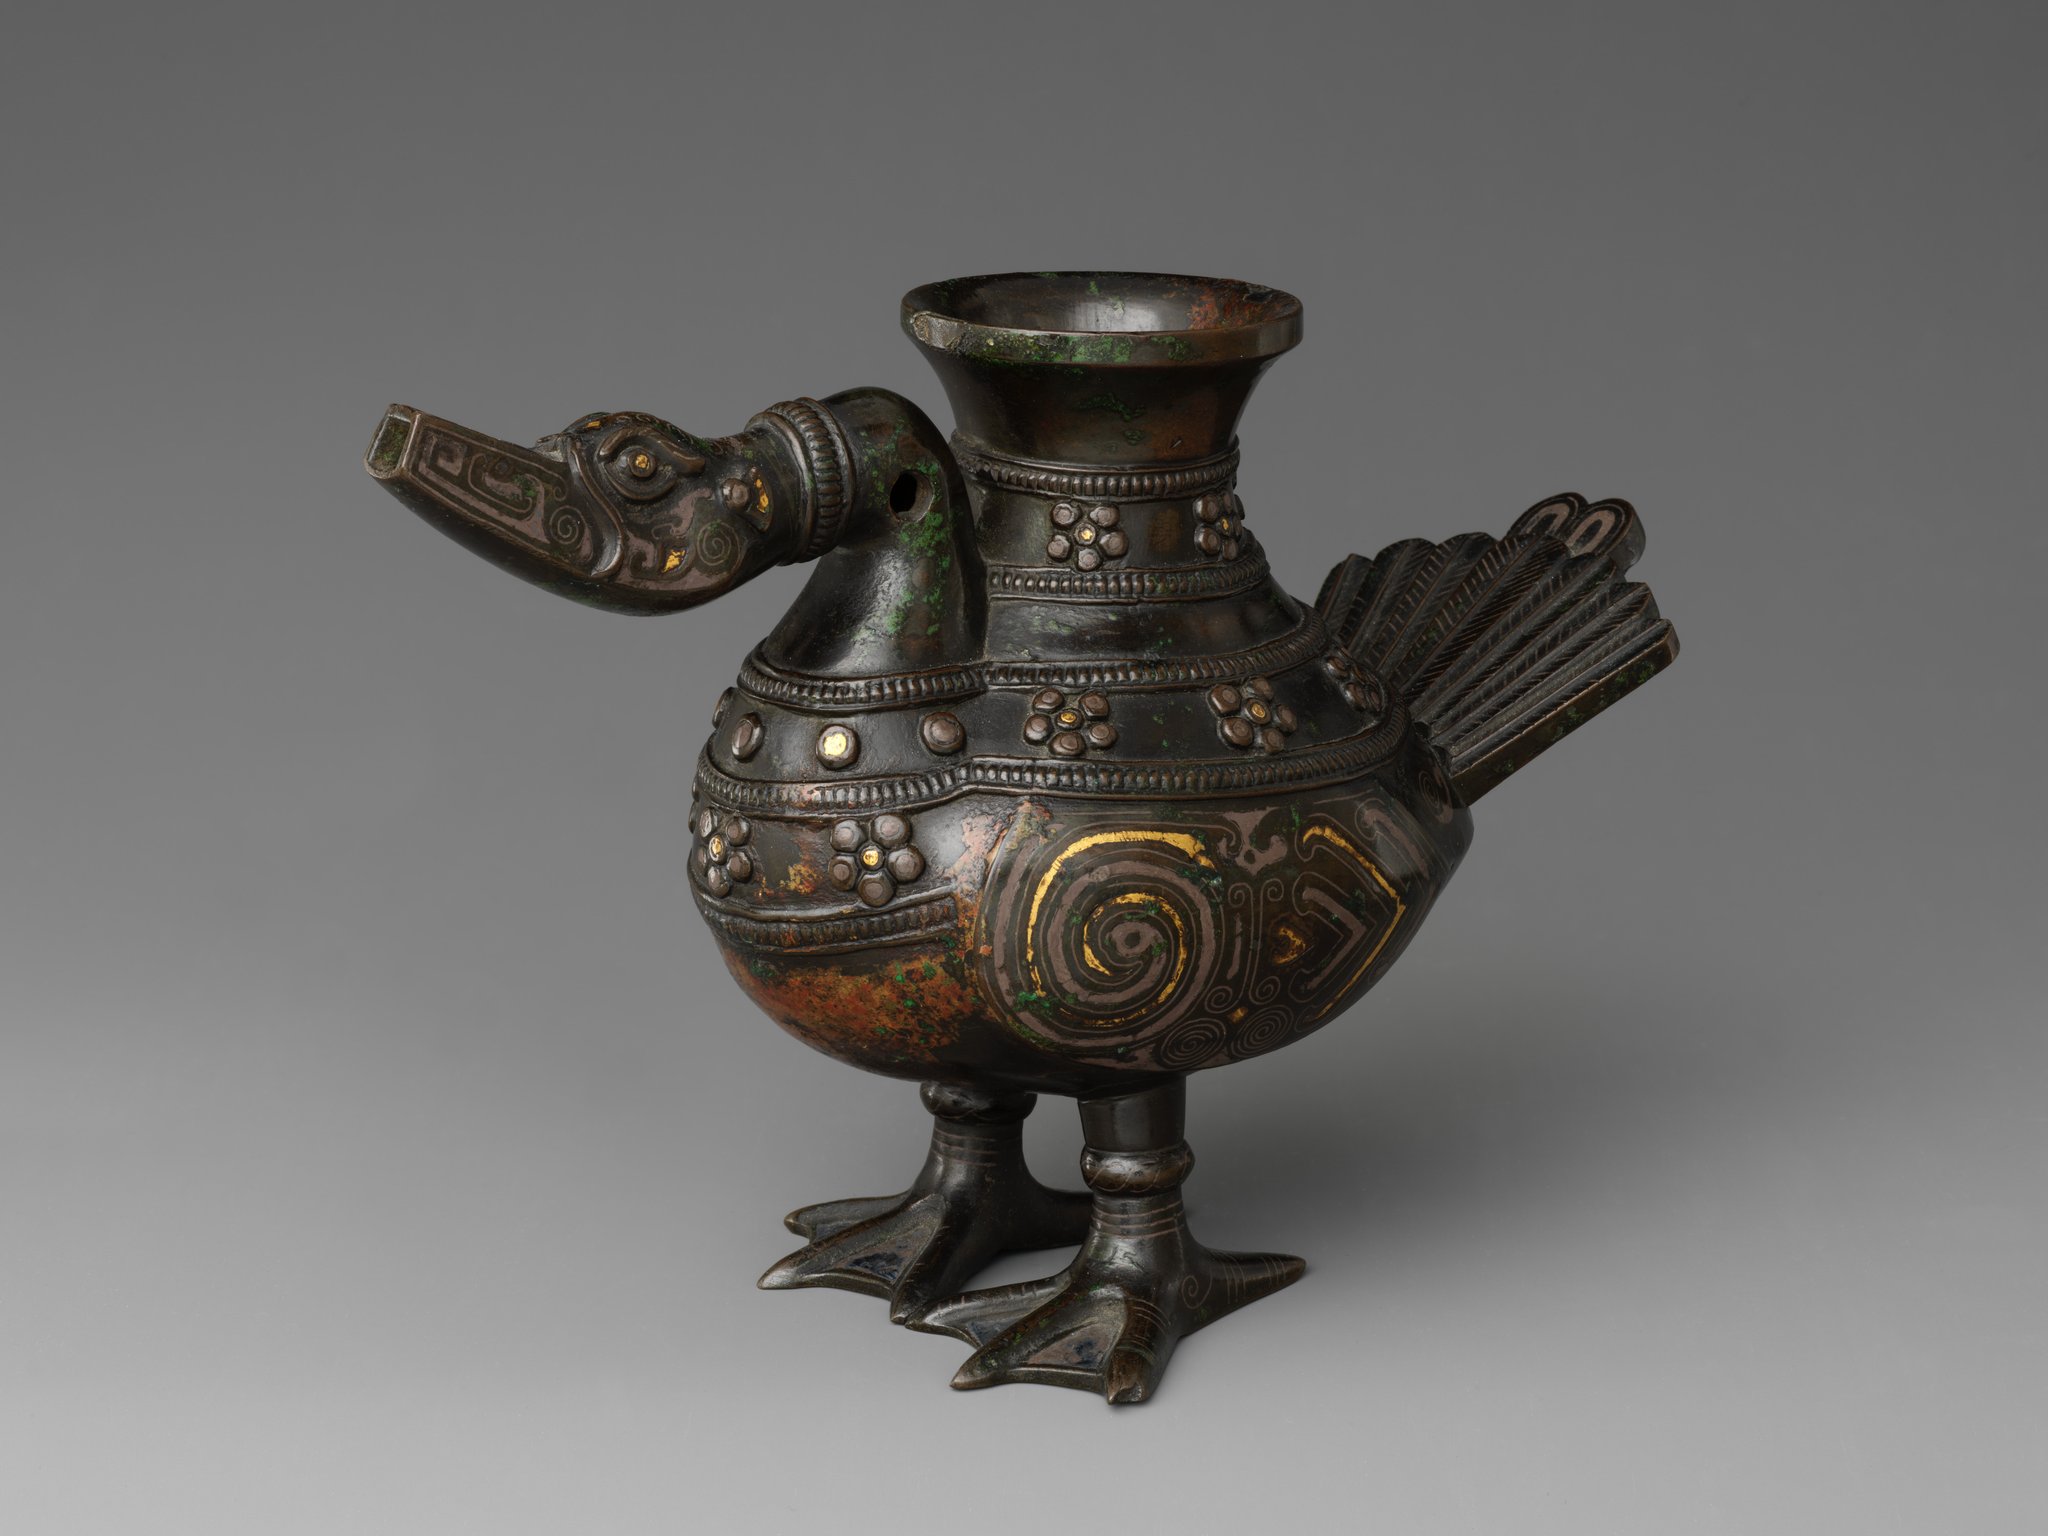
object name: vessel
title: Vessel in the shape of a waterfowl (fuzun)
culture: chinese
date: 1401-1600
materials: copper alloy, gold, silver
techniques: inlay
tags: birds